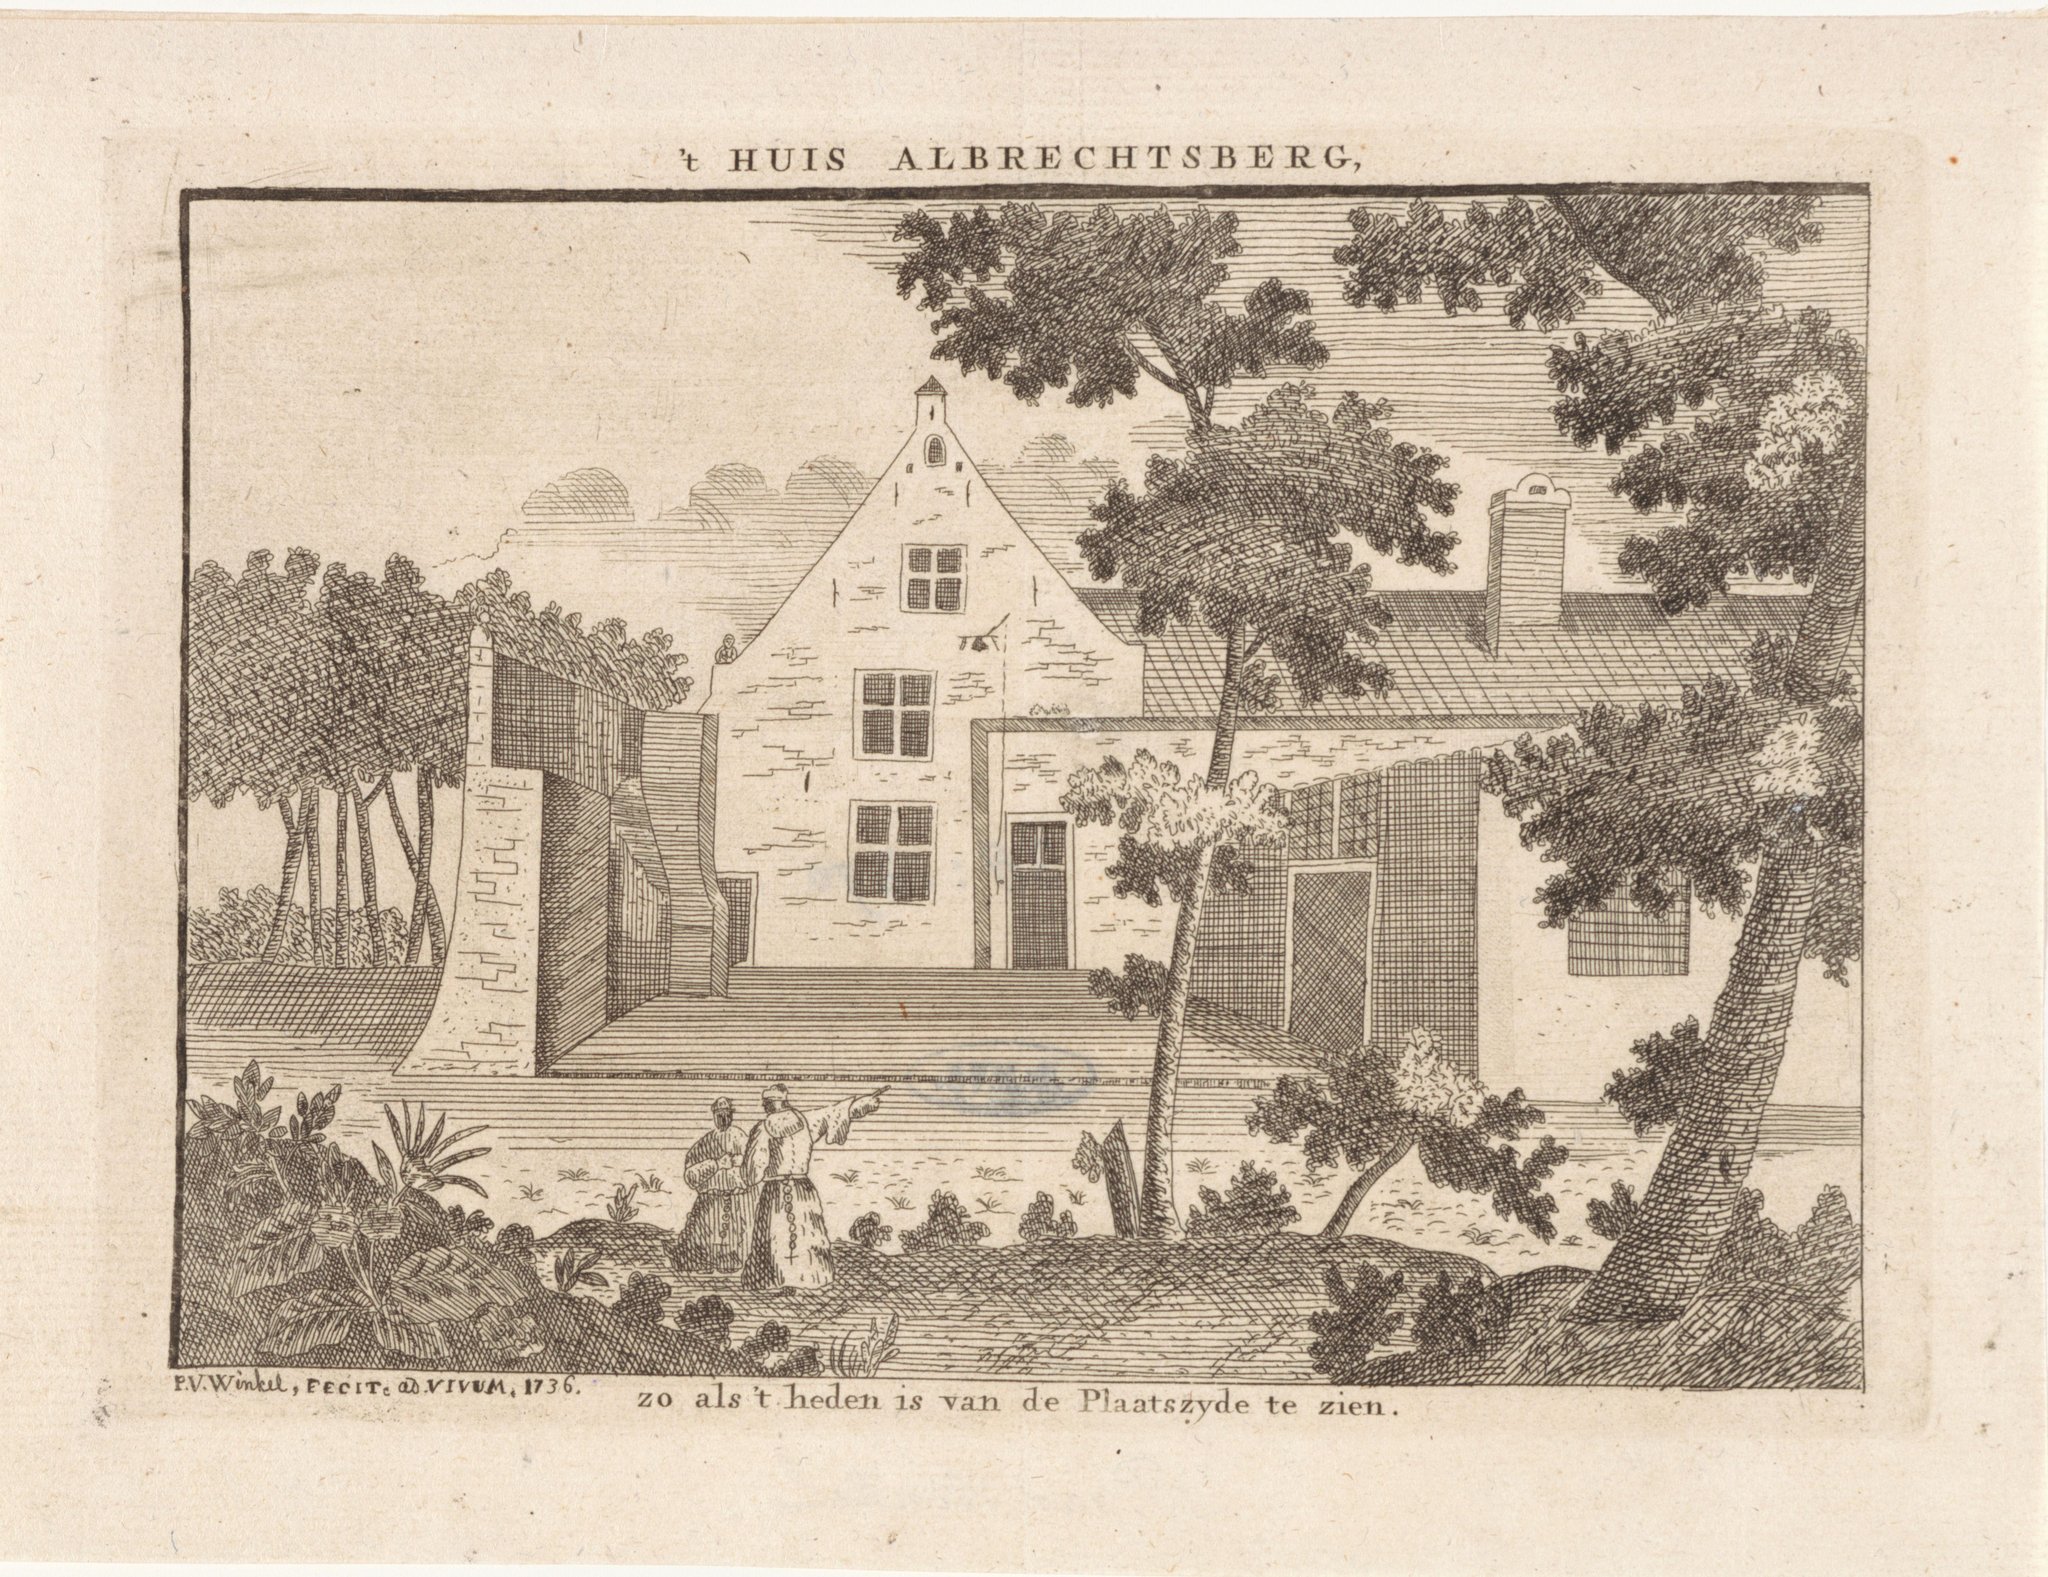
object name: print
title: Gezicht op het voormalige kasteel Aalbertsberg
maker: pieter van winkel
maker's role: print maker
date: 1736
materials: paper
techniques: etching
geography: haarlem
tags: villa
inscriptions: collector's mark: Lugt 2228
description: Gezicht op het voormalige kasteel Aalbertsberg, ook Huis te Bloemendaal genoemd. Linksvoor twee figuren.